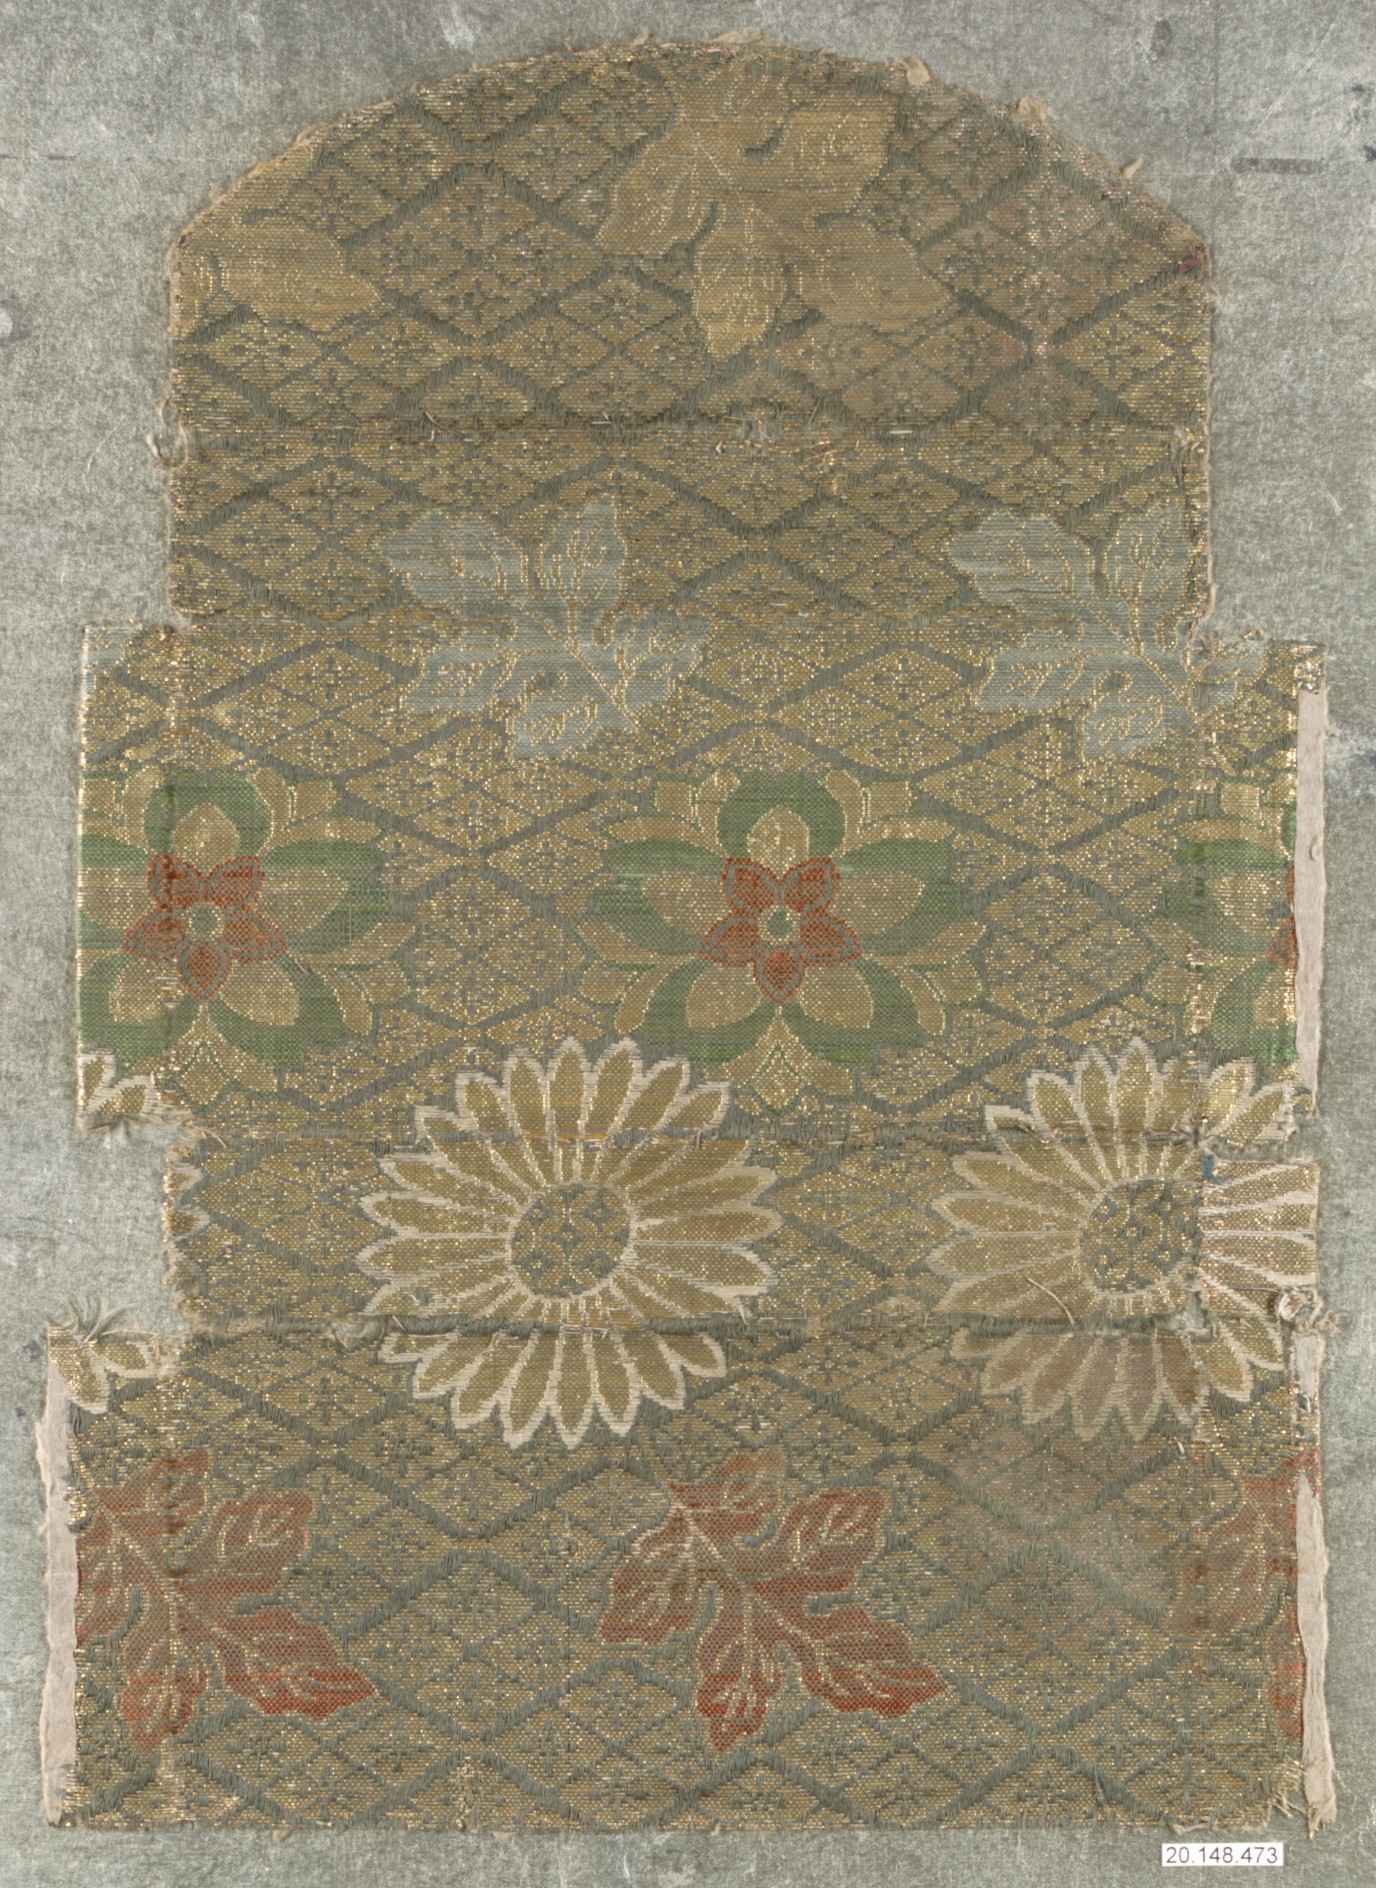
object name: piece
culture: japanese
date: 1601-1700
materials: silk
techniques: compound weave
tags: flowers,leaves